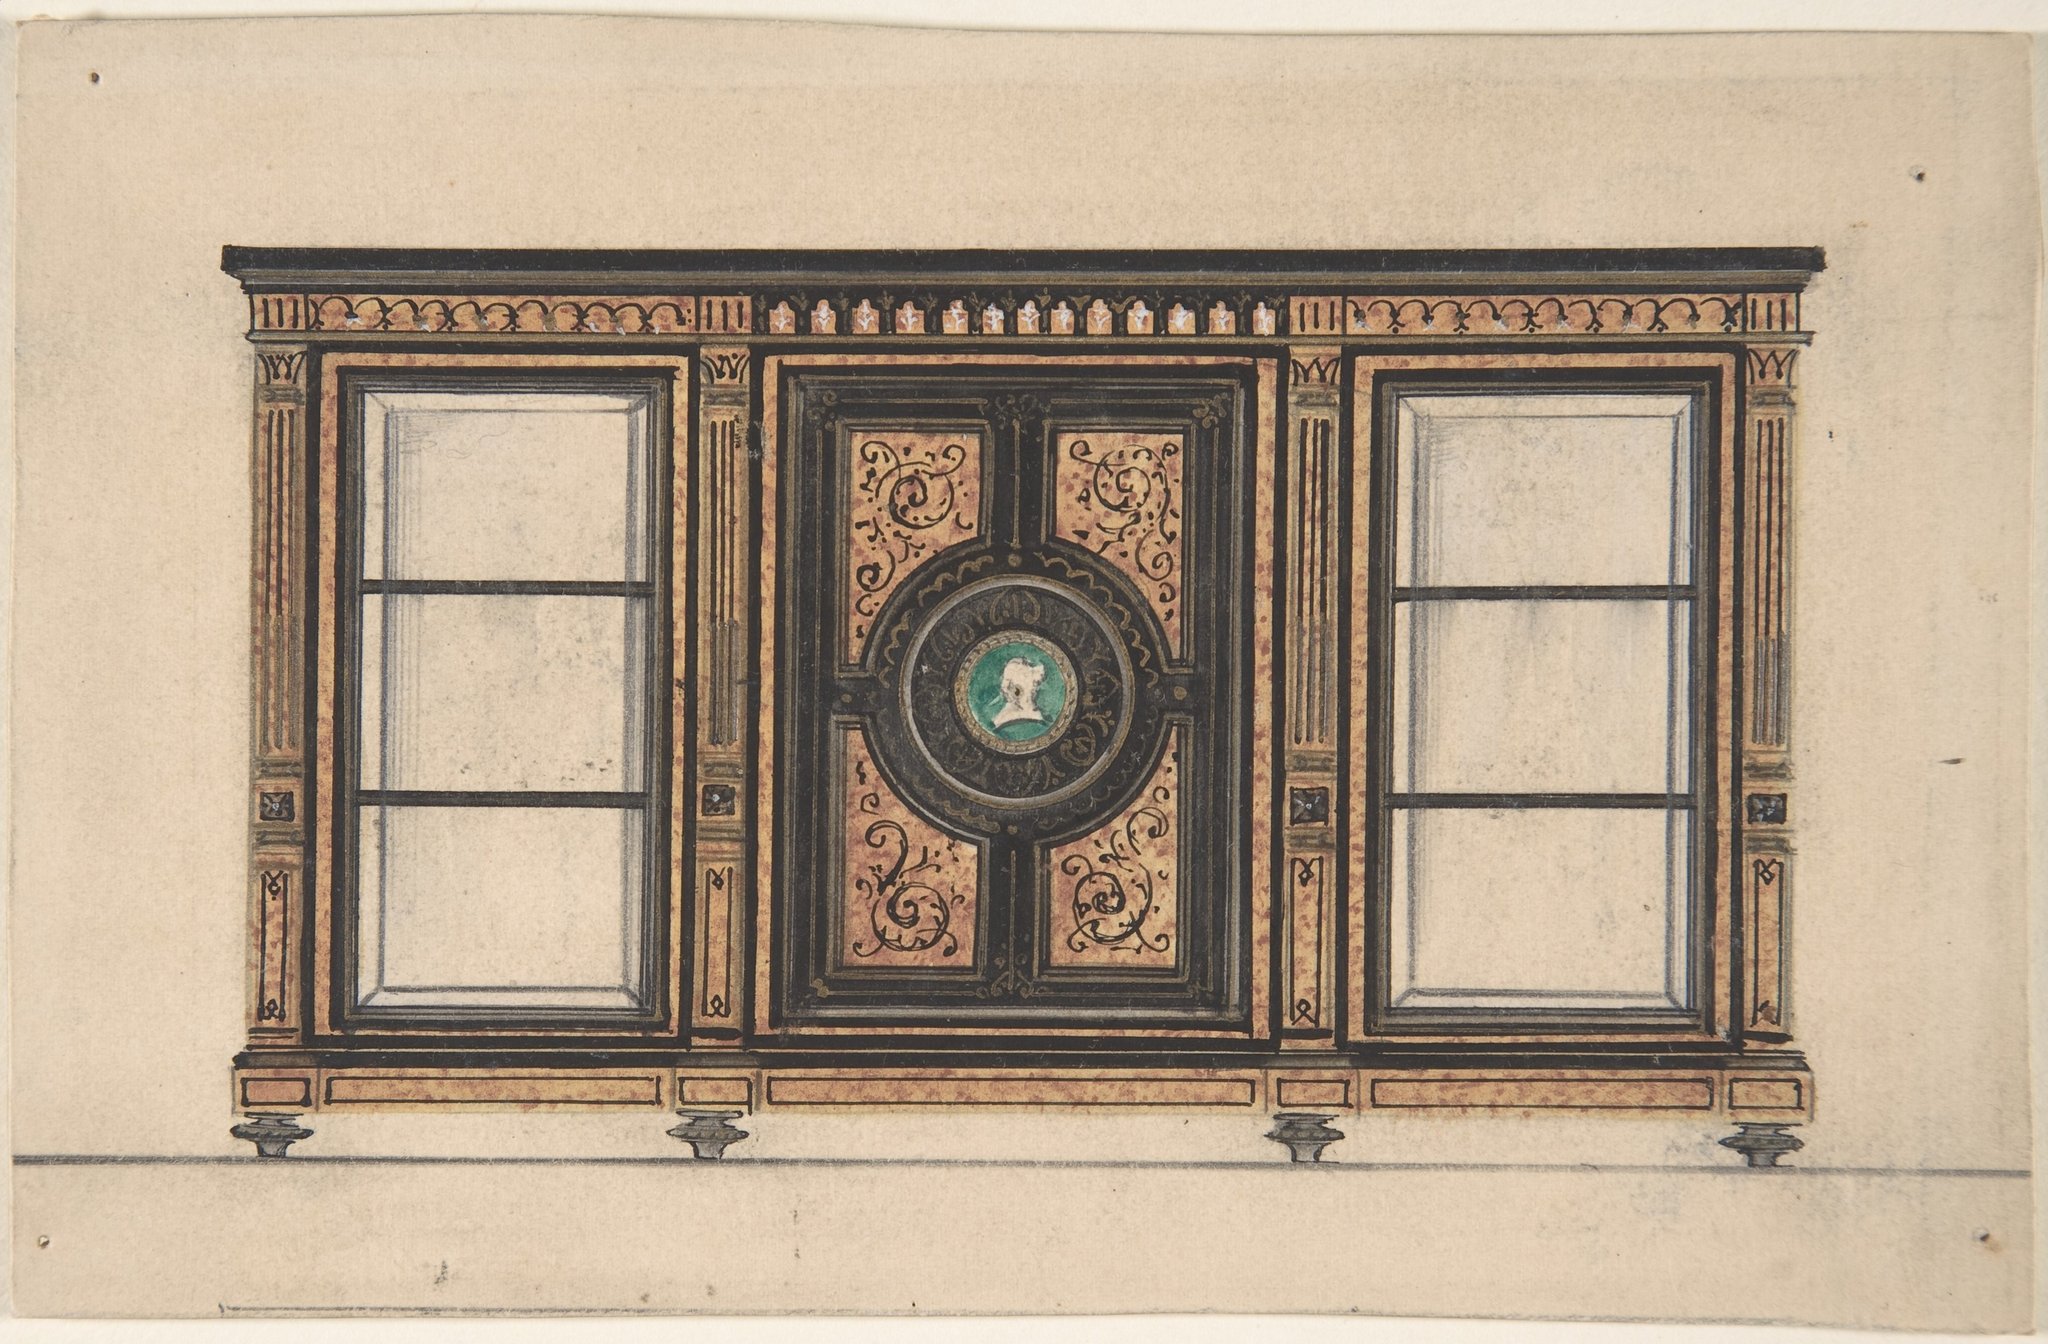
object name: drawing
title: Design for a Cabinet with Portrait Rondel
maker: anonymous, british, 19th century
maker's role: artist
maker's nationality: british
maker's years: 1800-1900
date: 1801-1900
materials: graphite, ink, watercolor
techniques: pen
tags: cabinets